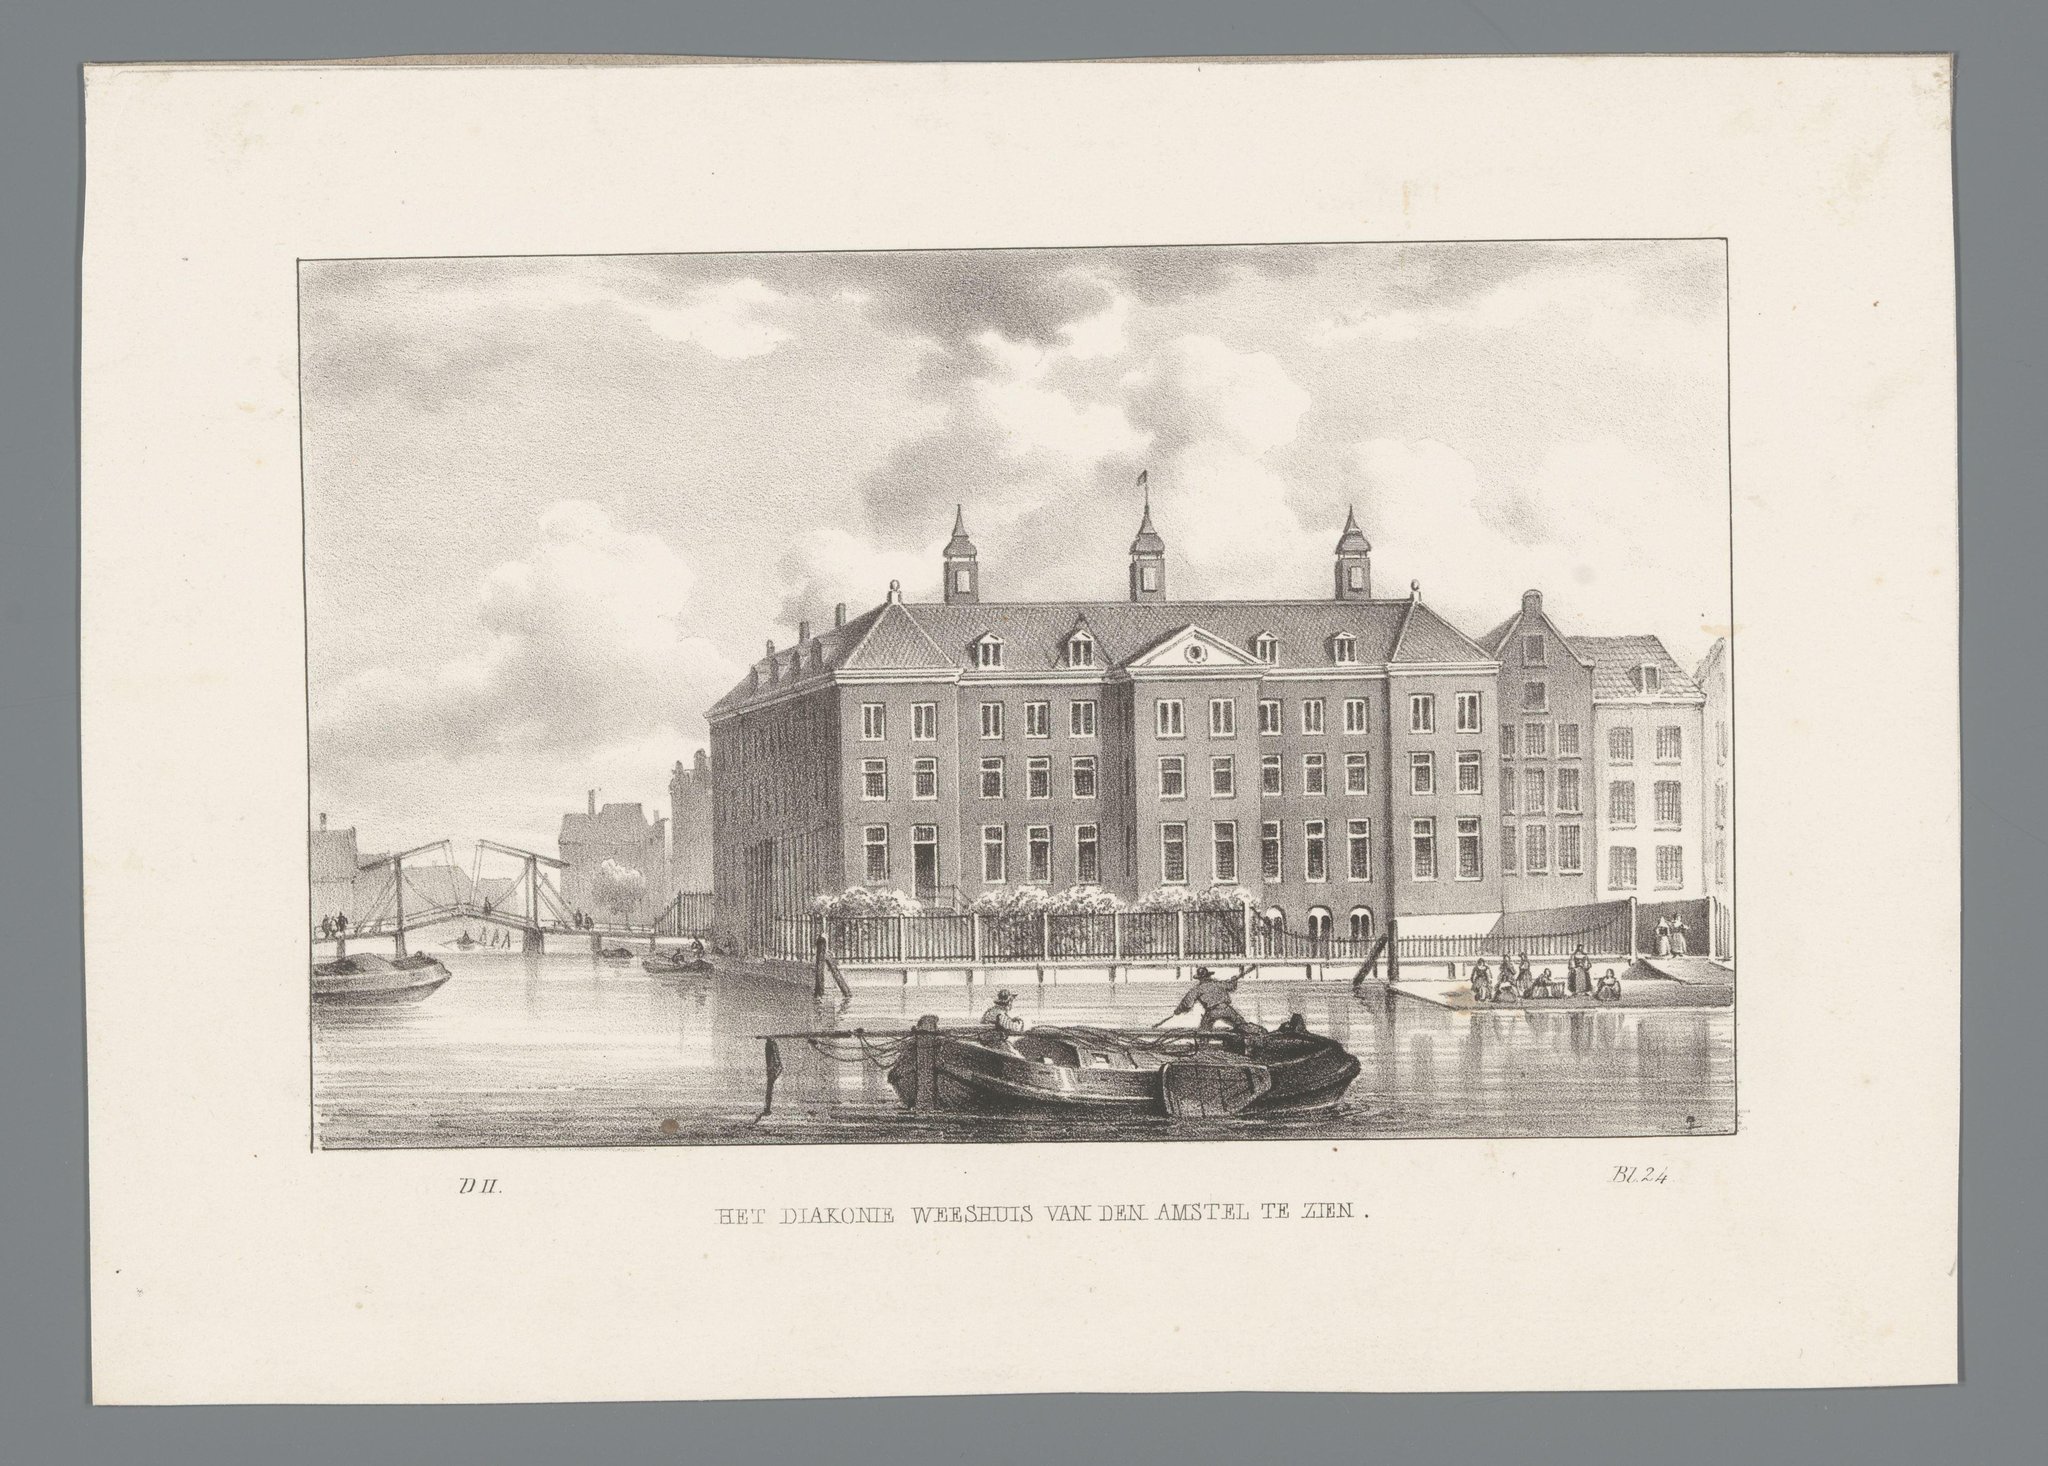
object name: print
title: Gezicht op het Diaconieweeshuis te Amsterdam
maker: johannes hilverdink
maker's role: draughtsman, painter, print maker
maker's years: 1813-1902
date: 1845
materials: paper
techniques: lithograph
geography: amsterdam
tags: orphanage, canals, waters (in city) (+ city(-scape) with figures, staffage)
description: Prent uit: Vijver, C. van der. Geschiedkundige beschrijving der stad Amsterdam (...). Amsterdam: Gebroeders Diederichs, 1845, dl. 2, p. 24.